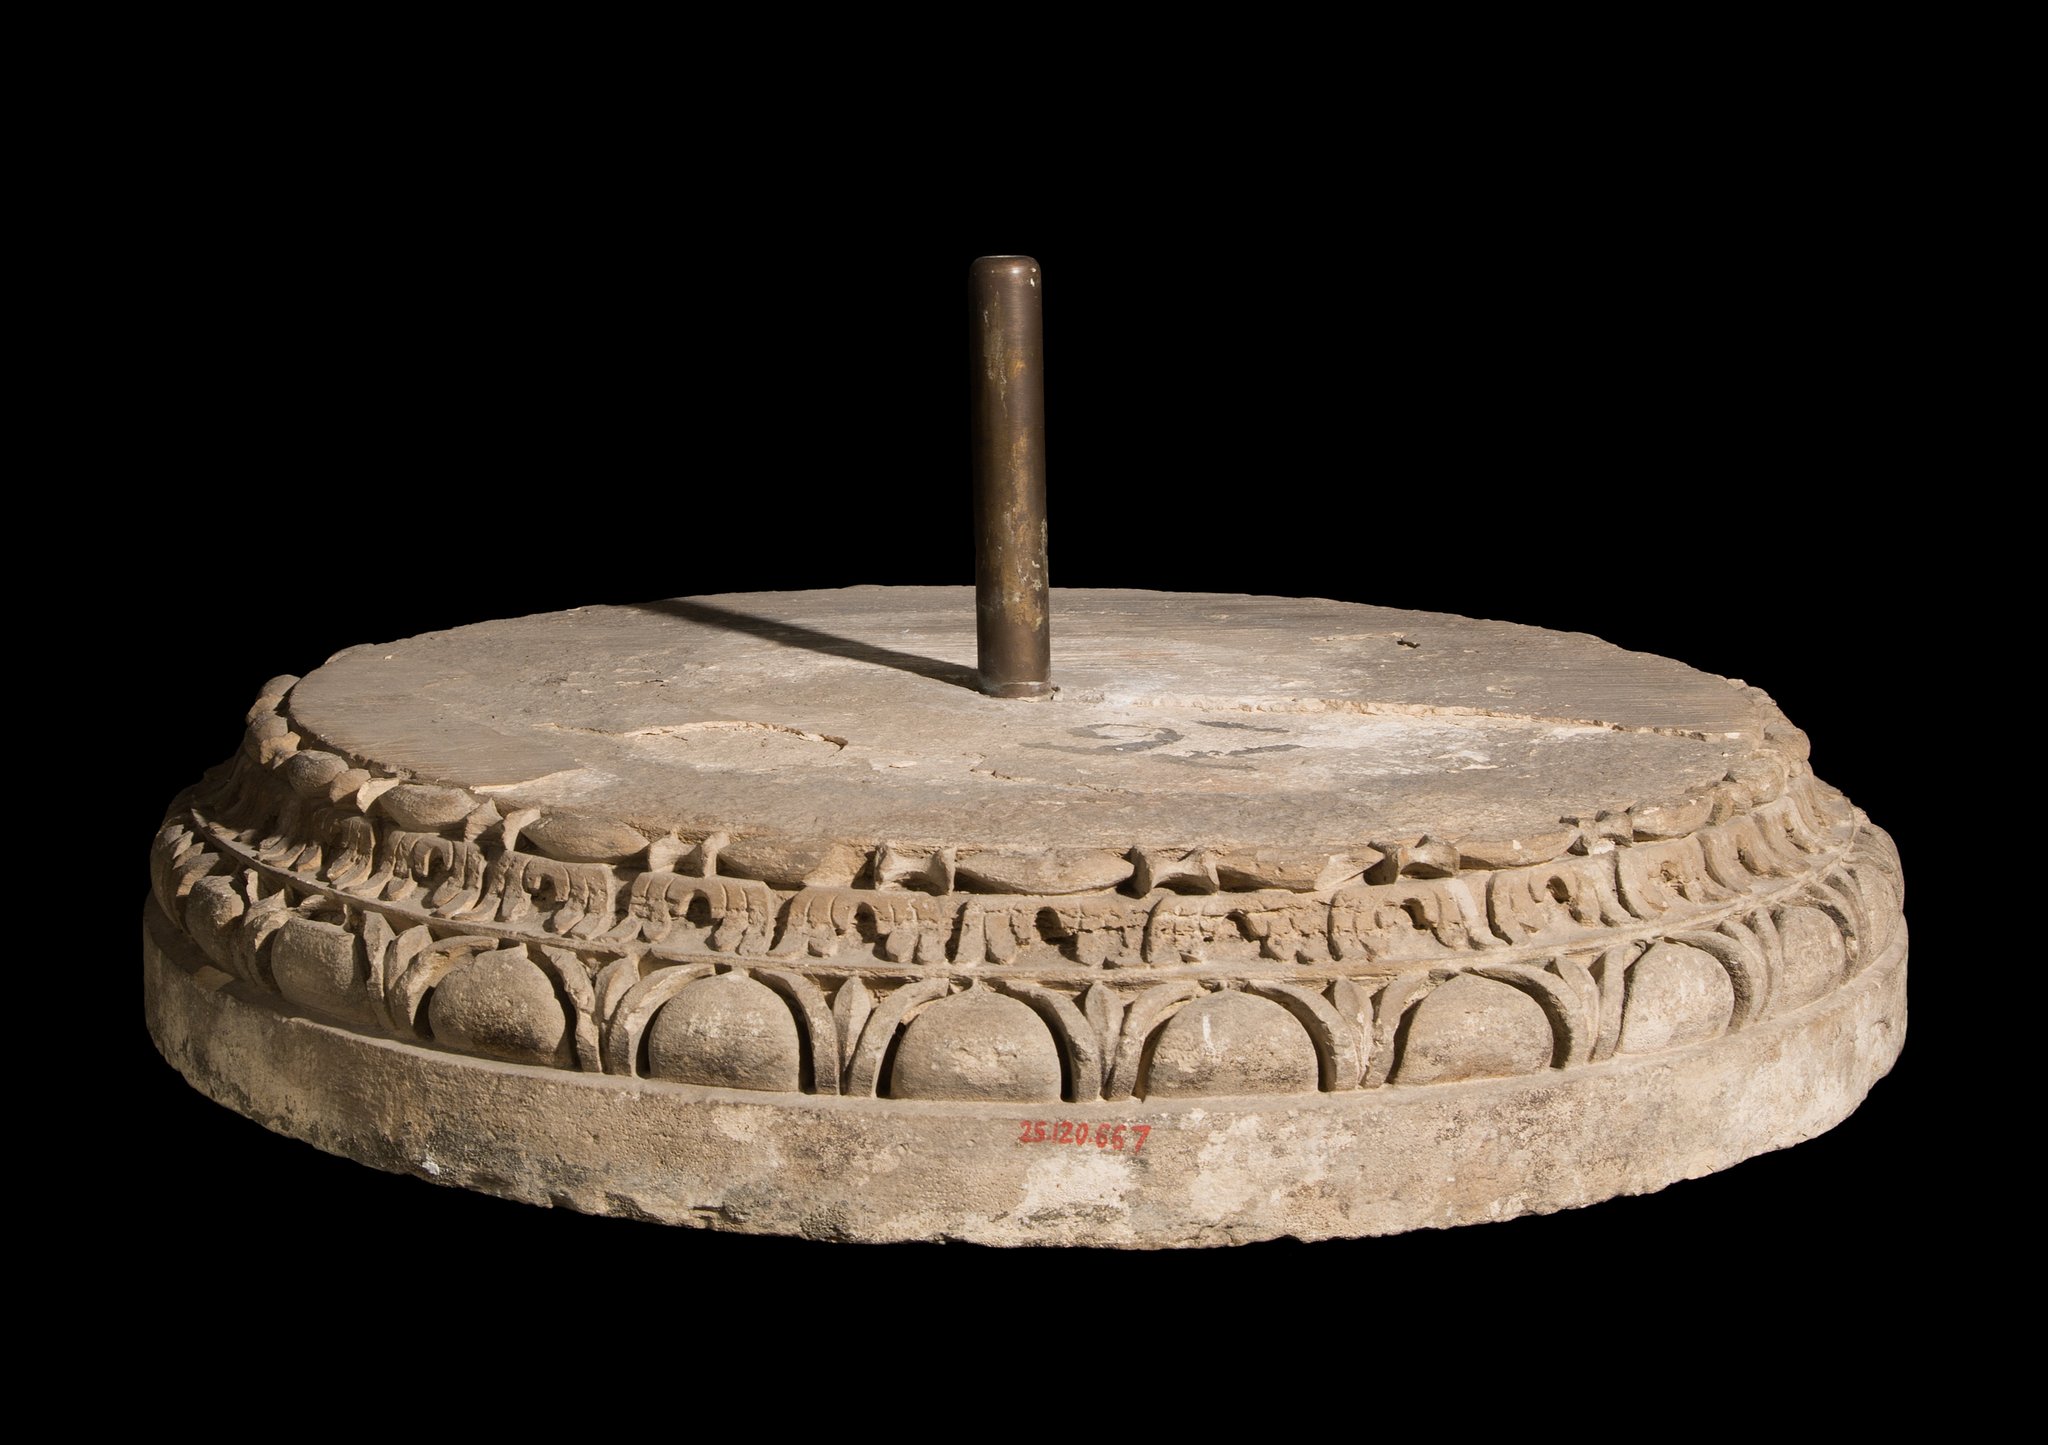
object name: base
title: Column Base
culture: french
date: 1167-1200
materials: stone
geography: france